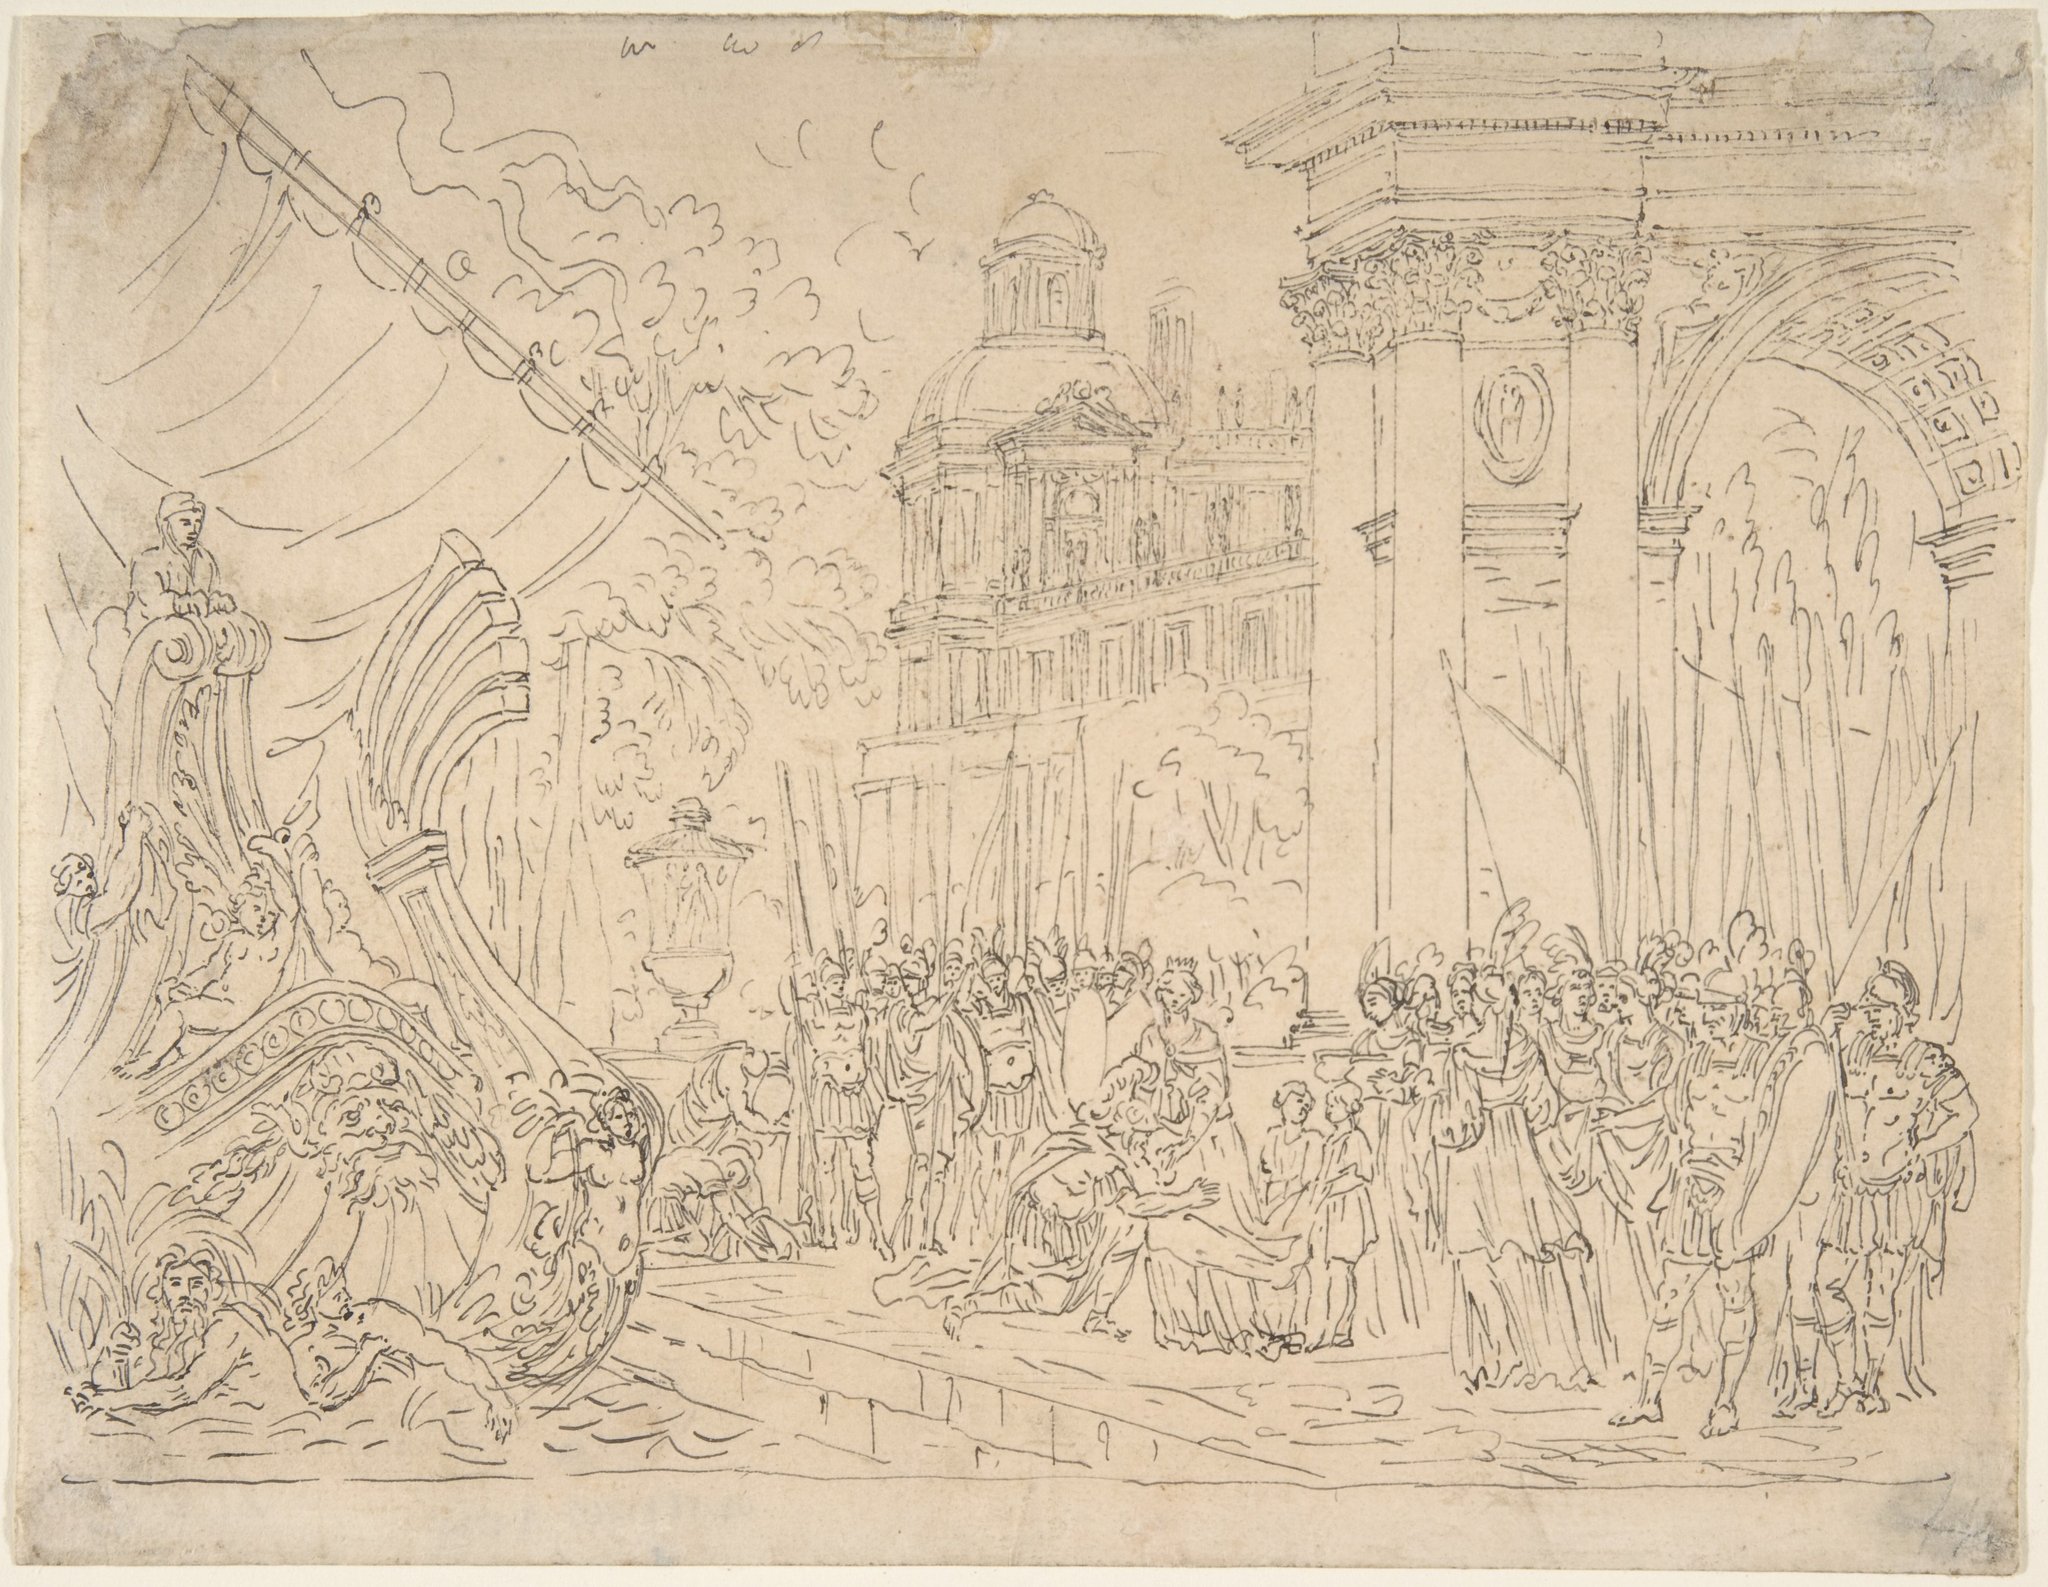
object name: drawing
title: Aeneas's Farewell to Dido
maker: jean le pautre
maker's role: artist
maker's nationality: french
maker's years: 1618-1682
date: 1618-1682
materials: ink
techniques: pen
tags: soldiers,men,women,aeneas,dido